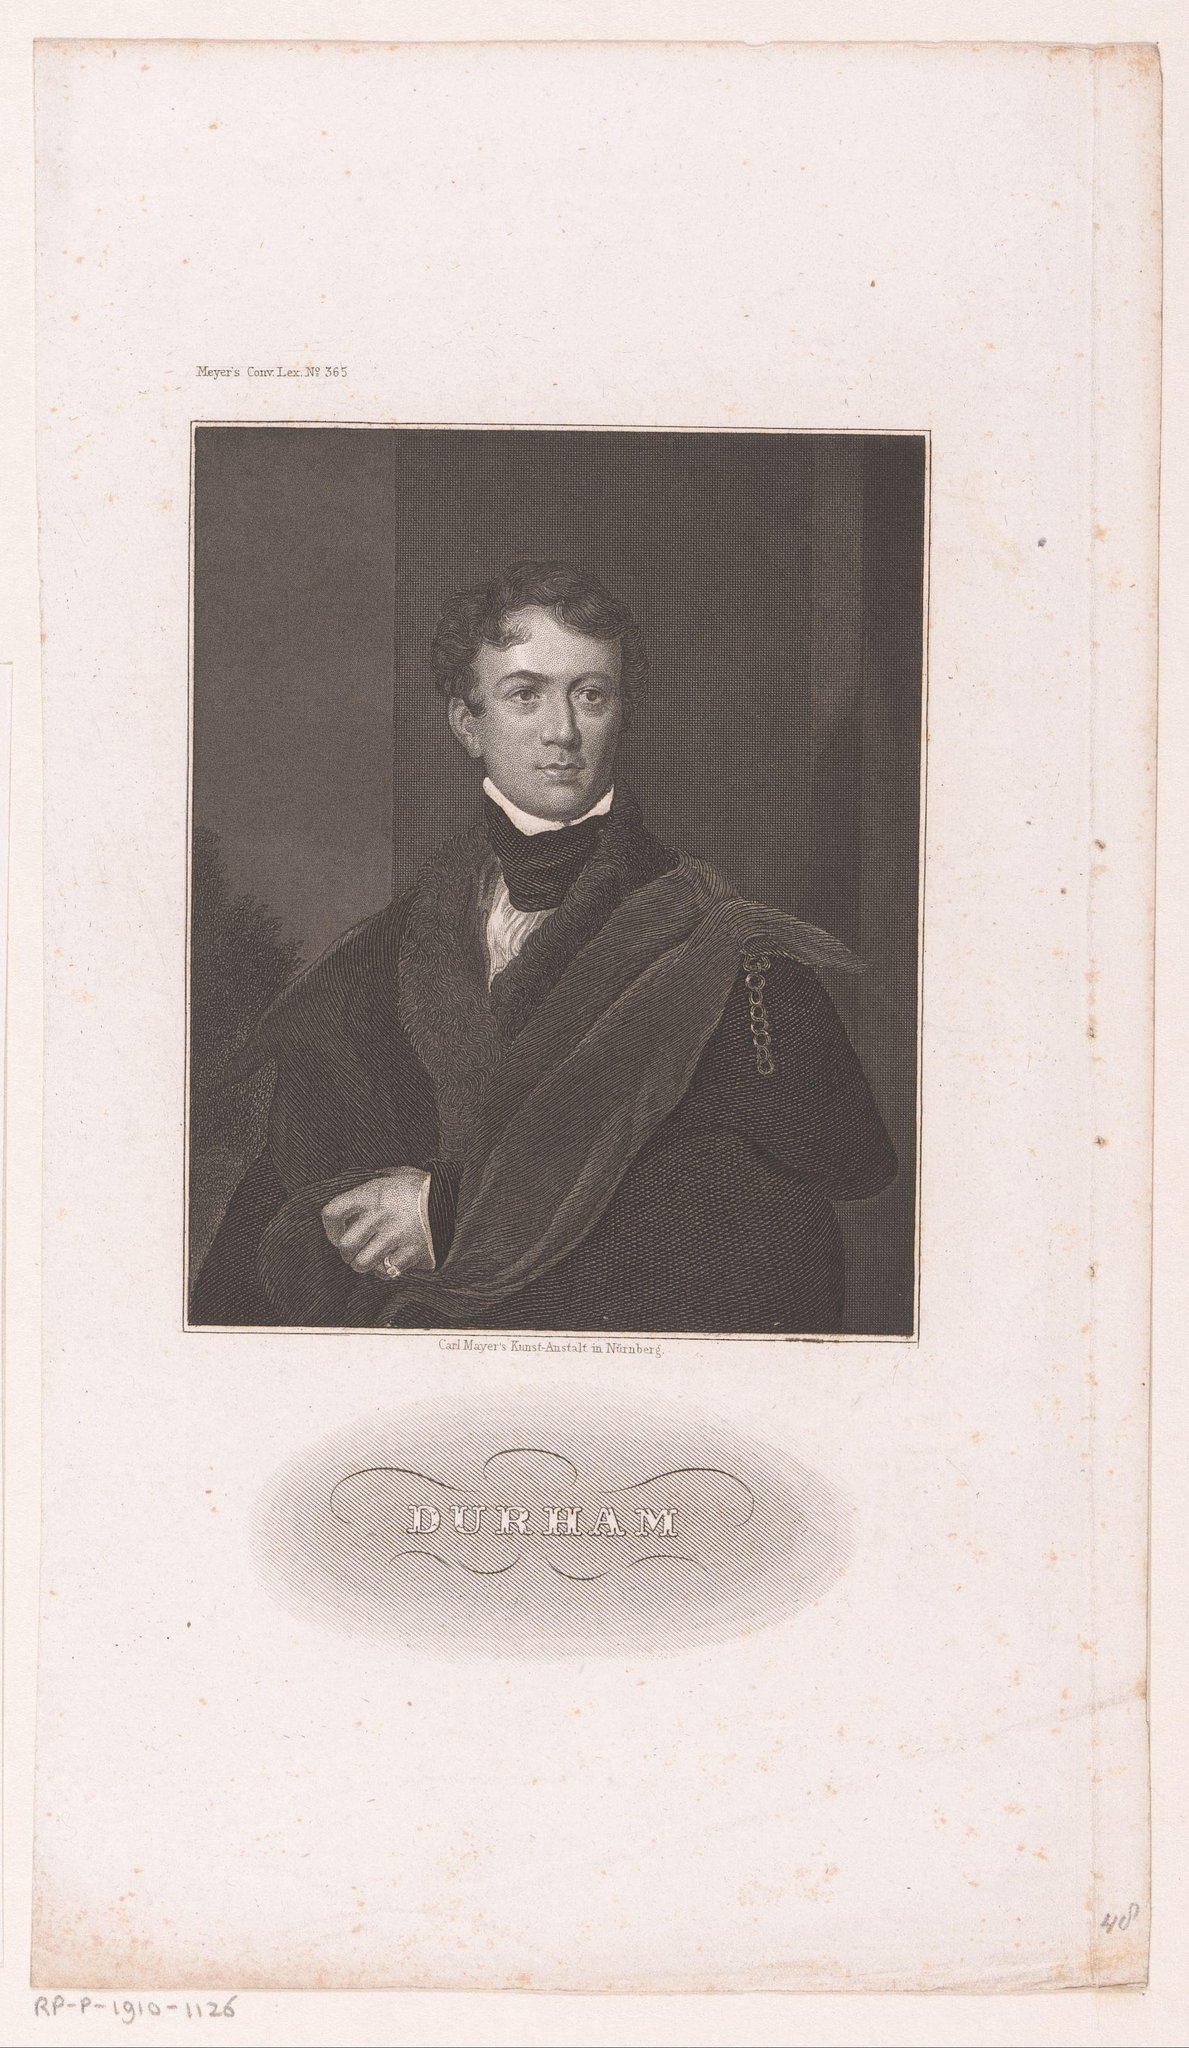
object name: print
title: Portret van John George Lambton, Earl of Durham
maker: carl mayer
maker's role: print maker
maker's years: 1798-1868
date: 1840-1855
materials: paper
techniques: engraving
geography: nuremberg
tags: historical persons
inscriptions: collector's mark: Lugt 2228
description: Prent afkomstig uit: Conversations-Lexikon für die gebildeten Stände, voor het eerst uitgegeven tussen 1840-1855.